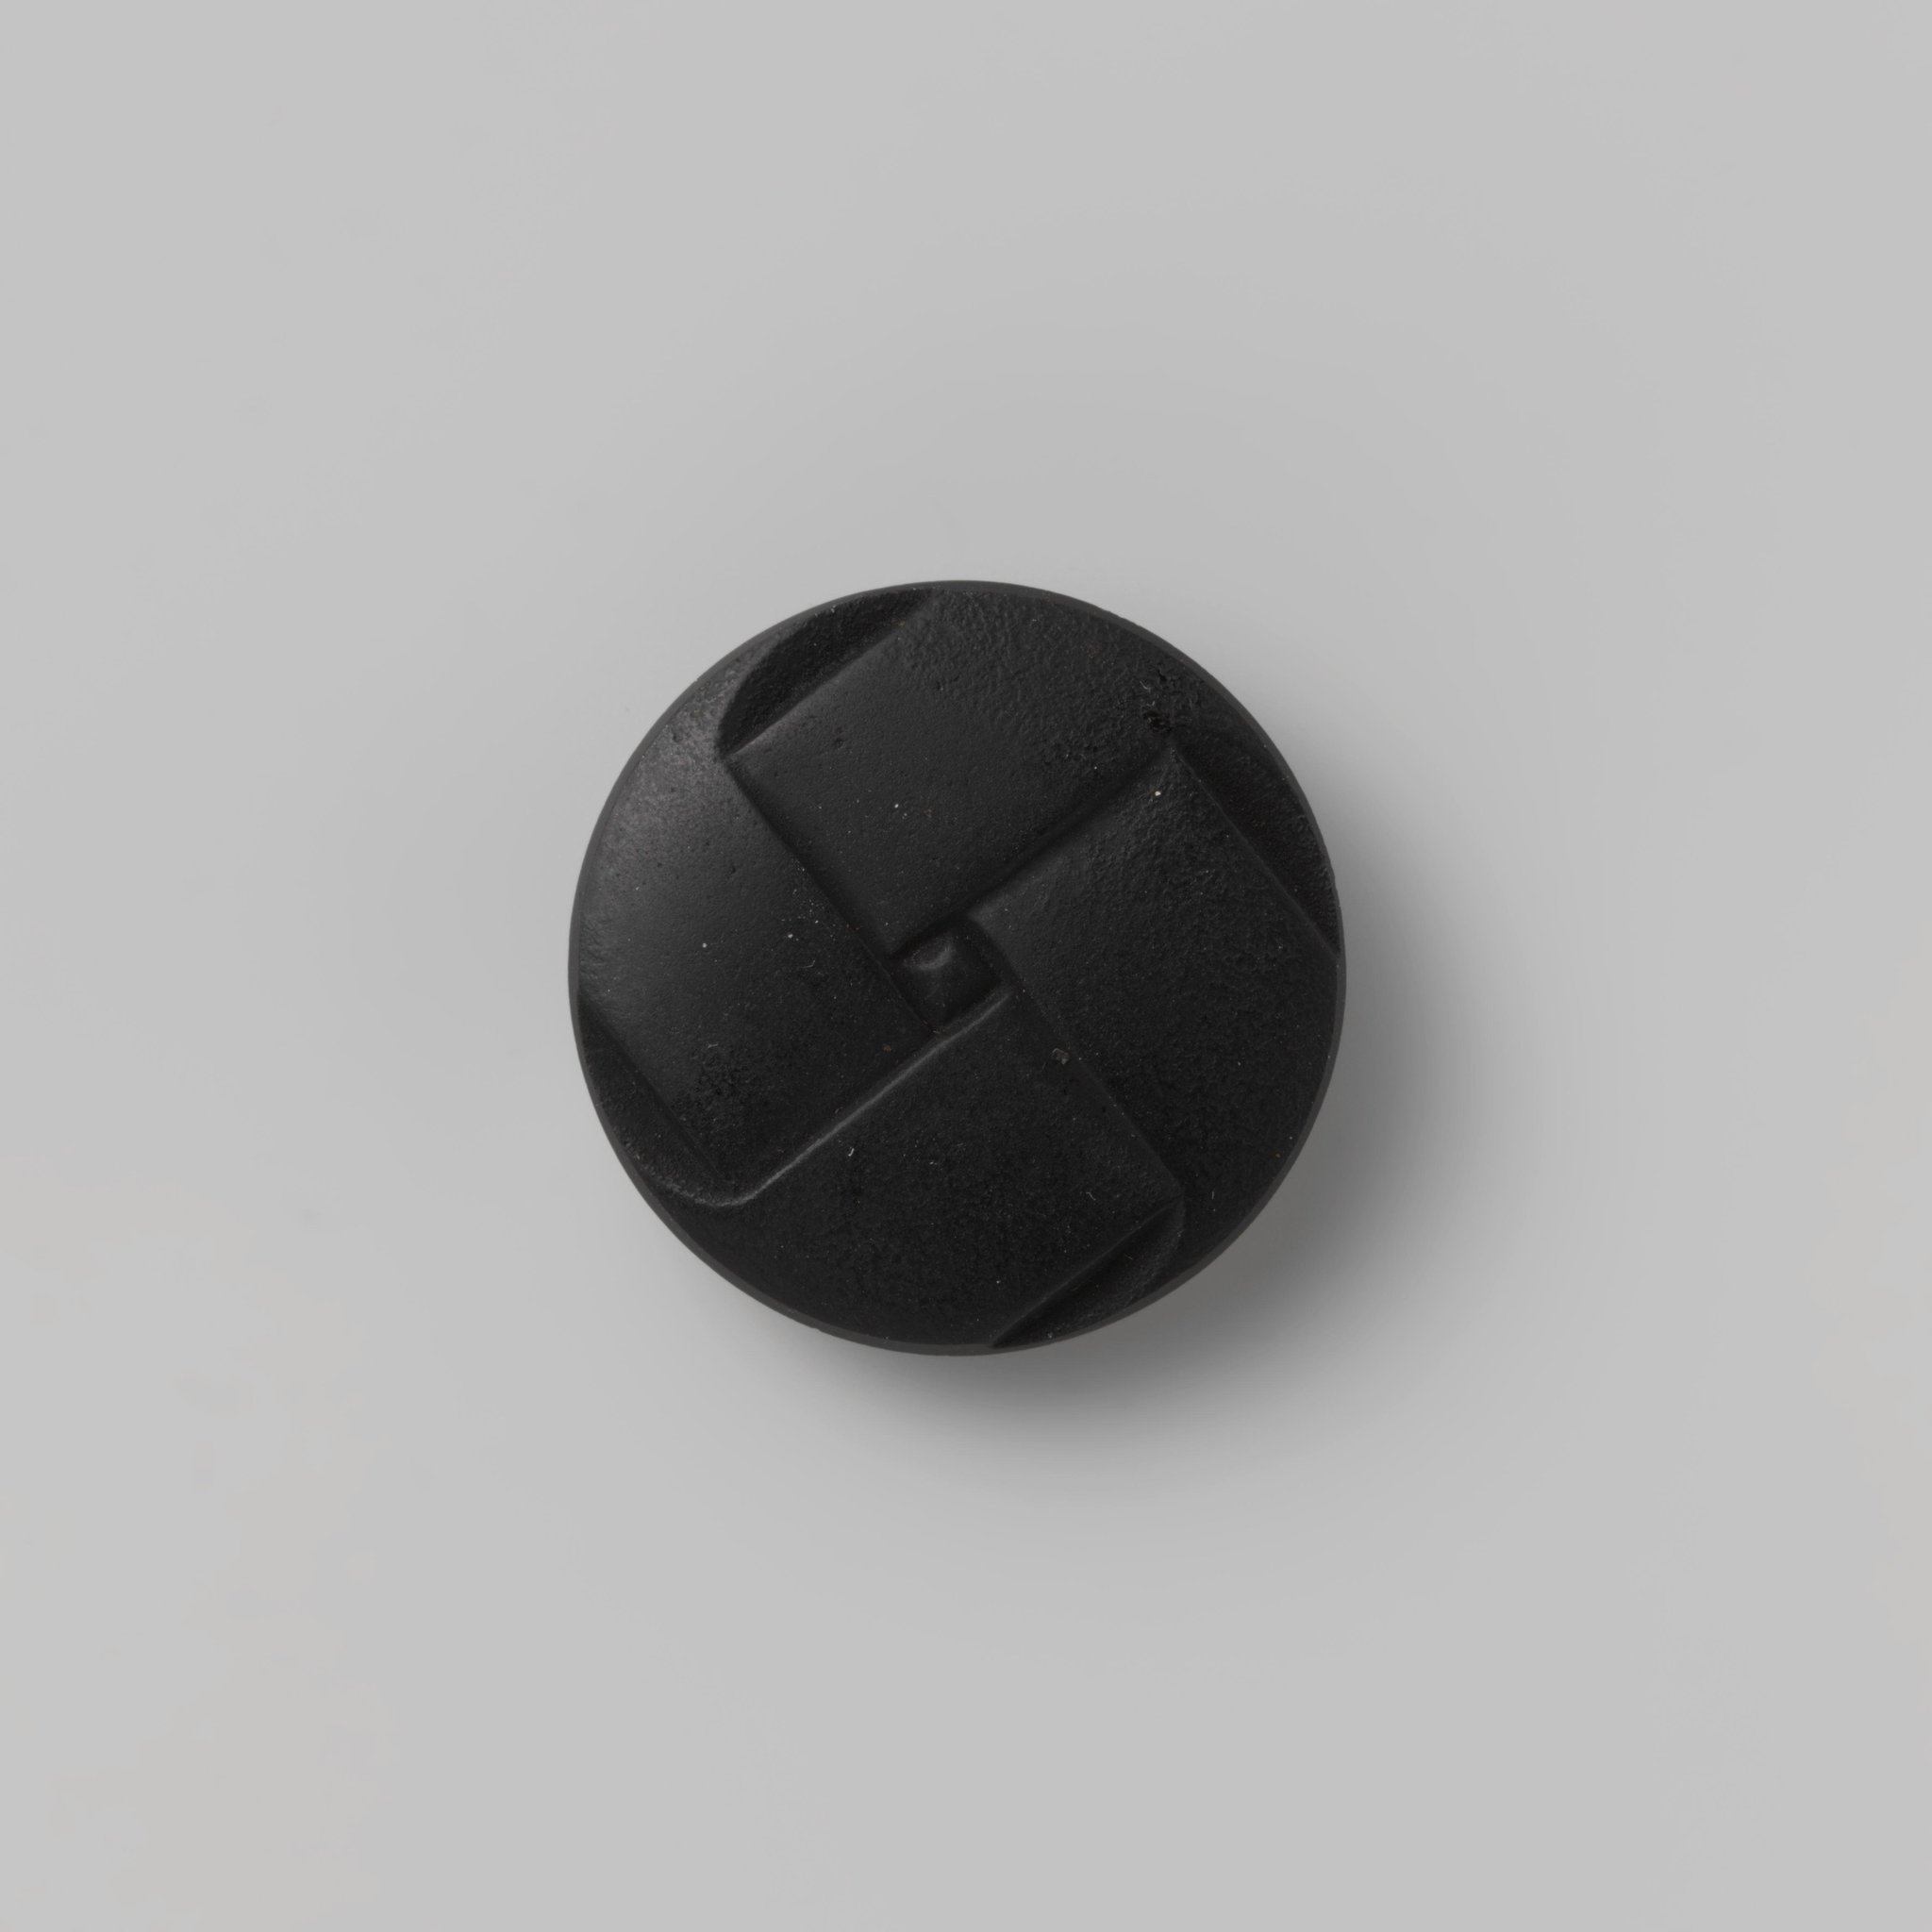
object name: mourning jewelry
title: Rouwbroche van glas en zilver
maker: Anonymous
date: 1880-1900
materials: glass, silver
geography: schoonhoven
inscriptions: import mark: ‘V’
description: Rouwbroche van zwart glas met vlechtmotief in reliëf en zilveren brochering voorzien van haaksluiting.